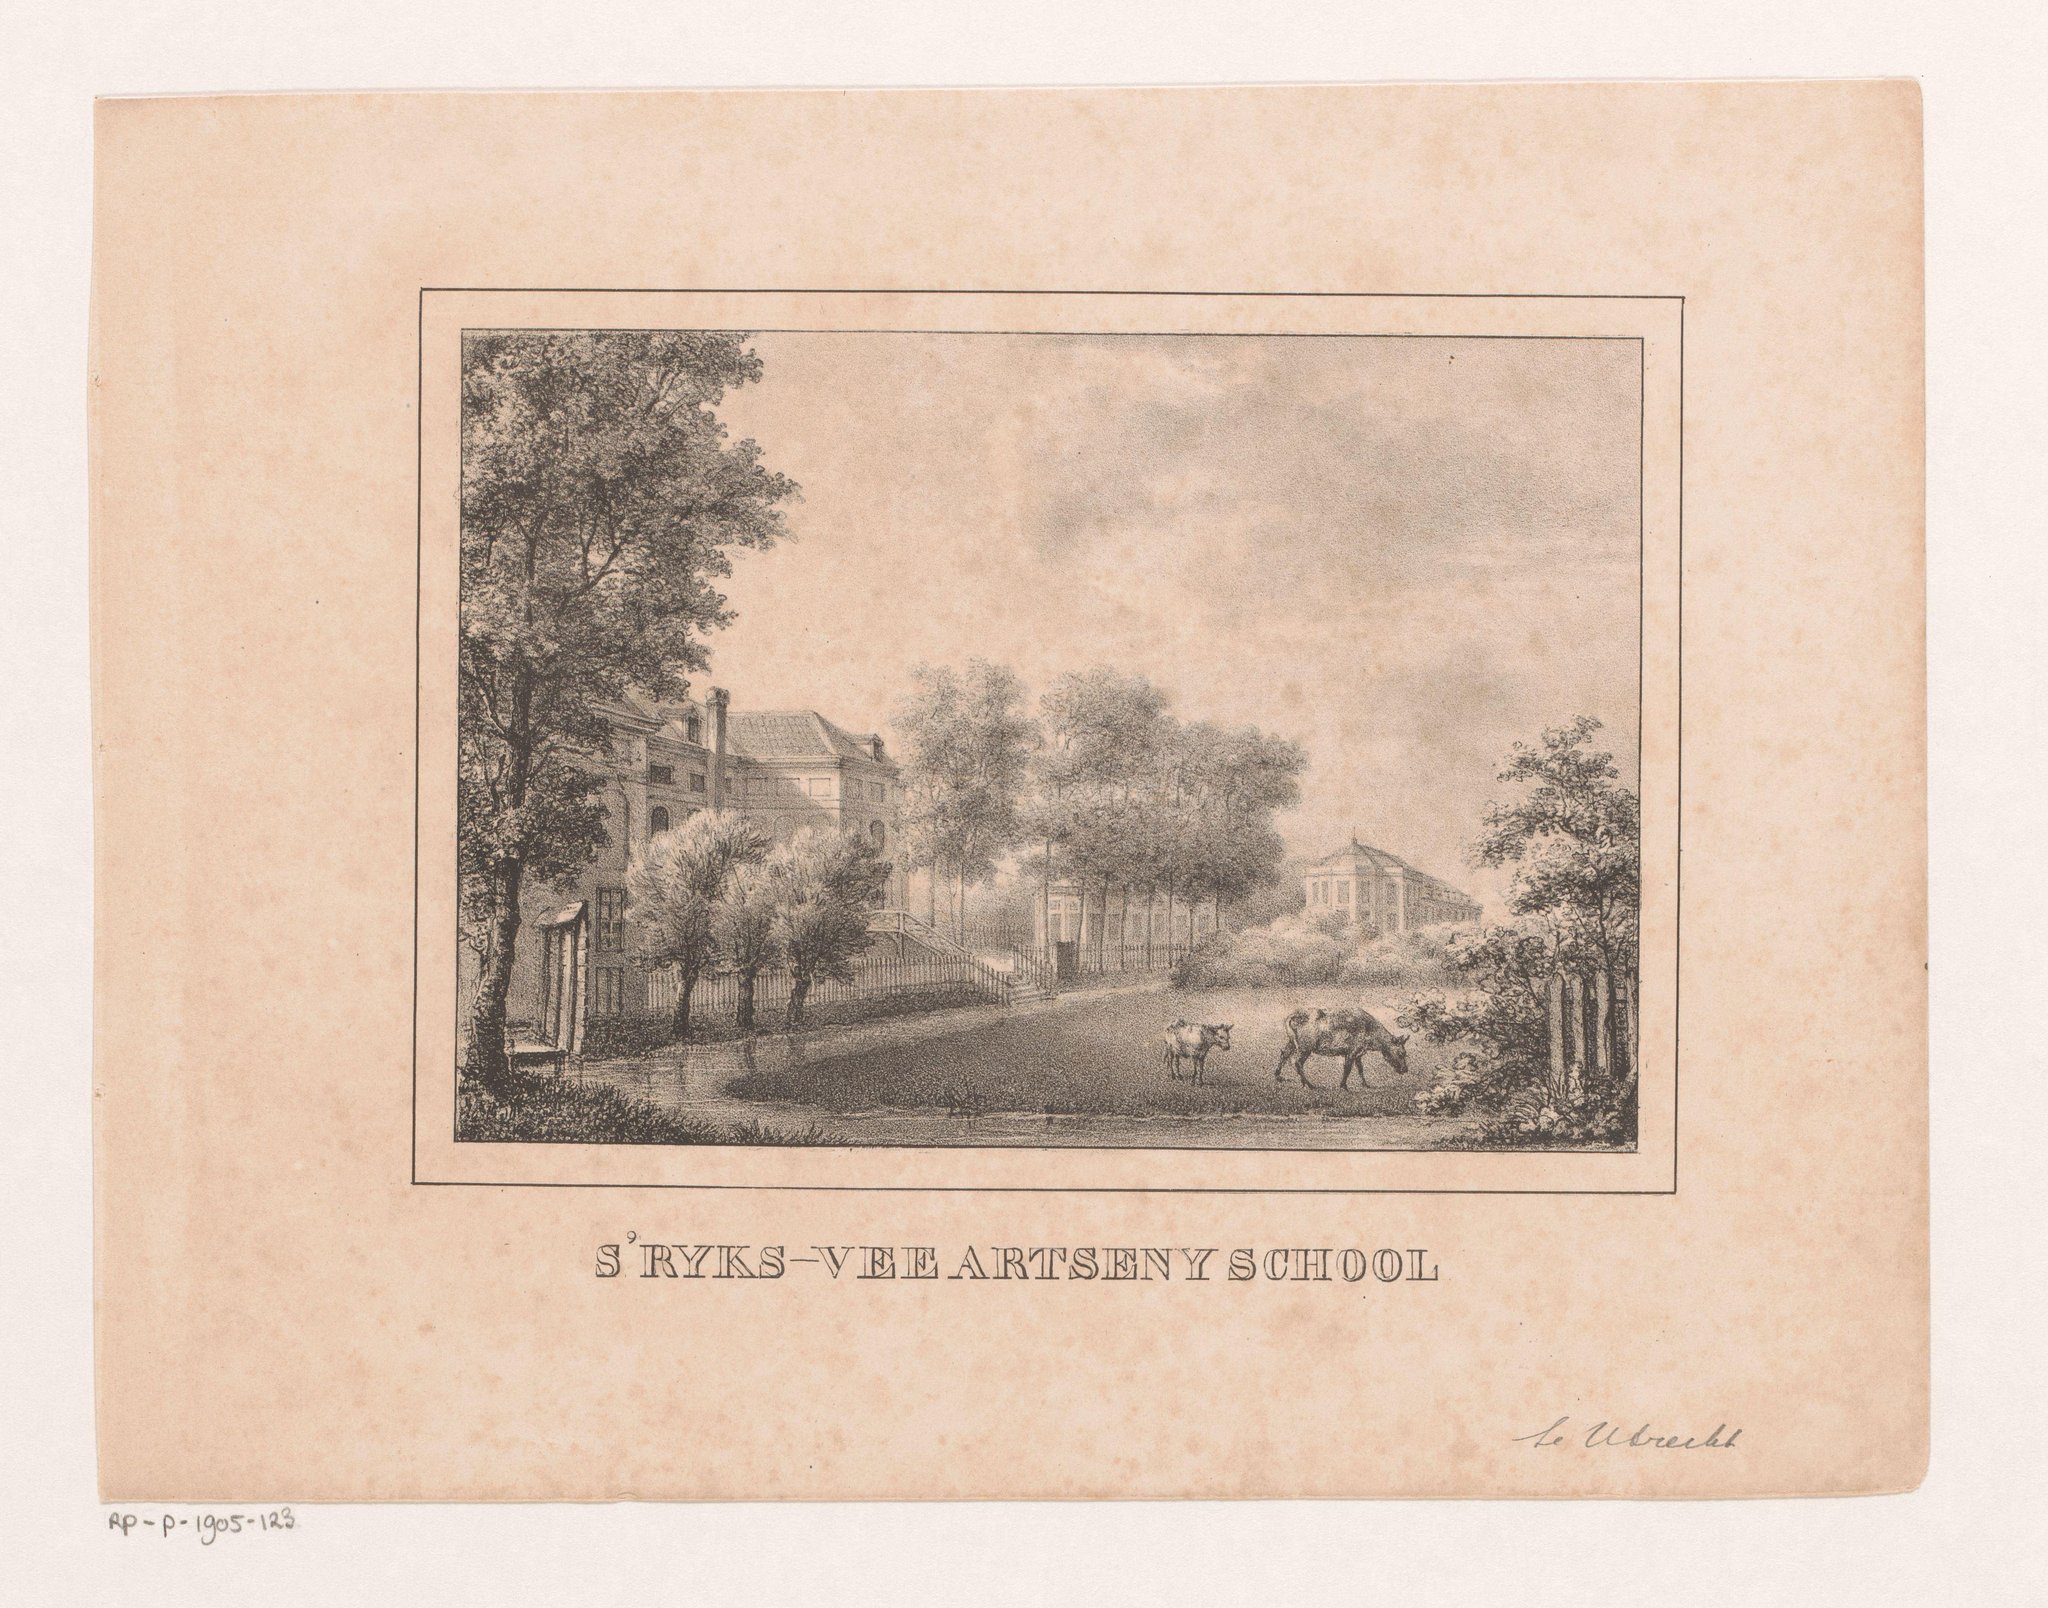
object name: print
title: Achterzijde van de Rijks Veeartsenijschool in Utrecht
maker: michel mourot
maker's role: draughtsman, print maker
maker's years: 1803-1847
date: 1829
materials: paper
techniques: lithograph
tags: cow, landscape with other man-made constructions not mentioned above, e.g.: graveyards, playgrounds, etc., veterinarian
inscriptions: collector's mark: Lugt 2228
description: Uitgegeven in: Gezigten van buitenplaatsen en gebouwen gelegen tusschen de Stad Utrecht en de Grebbe. Utrecht, I. P. Houtman: 1829.